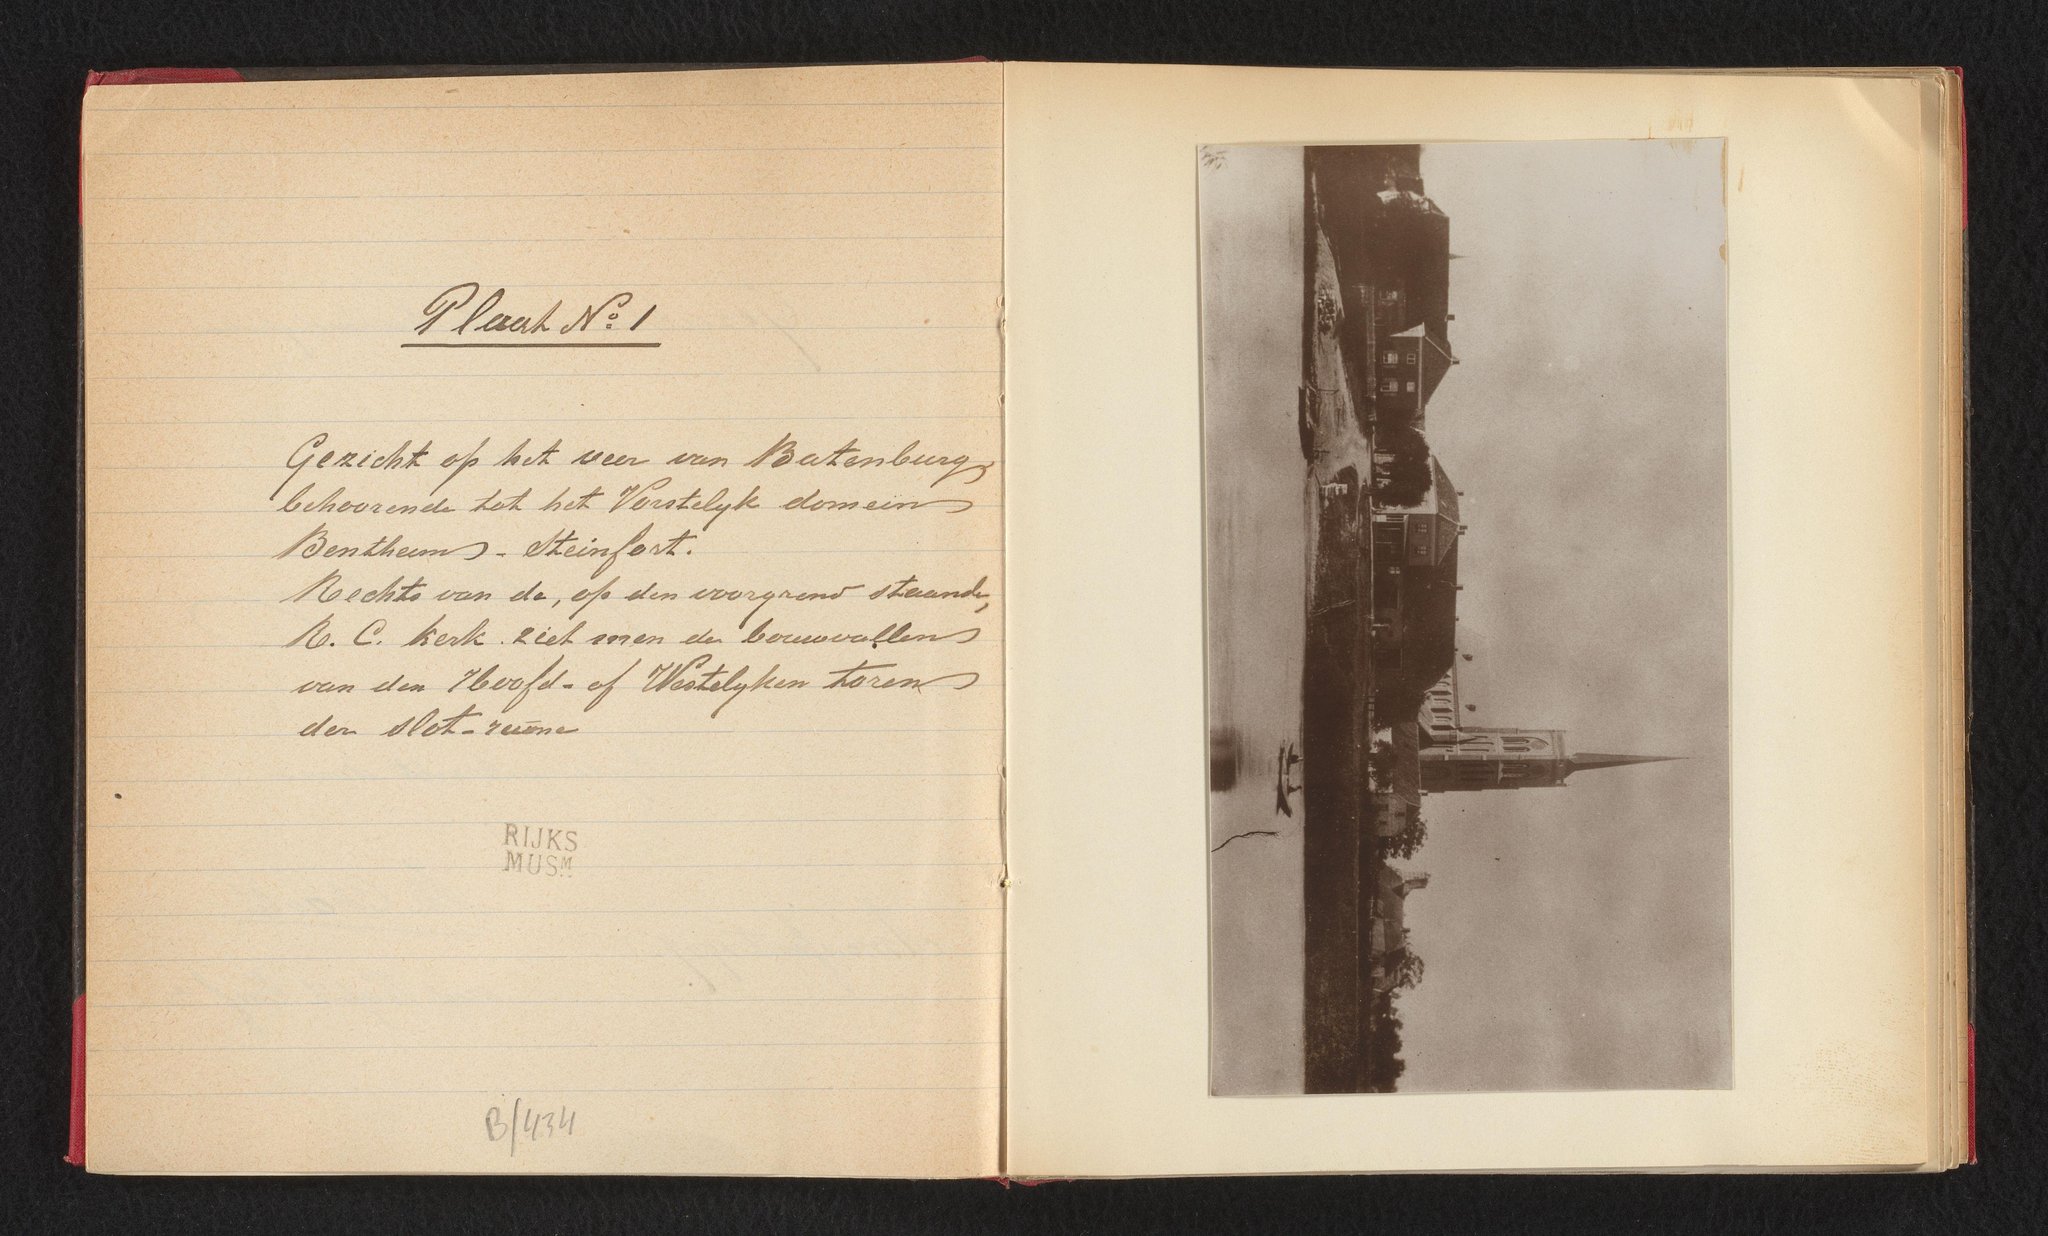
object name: photograph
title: Gezicht op Batenburg en de Sint-Victorkerk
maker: benjamin charlé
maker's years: 1845-1925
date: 1902-1907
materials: paper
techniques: collodion silver print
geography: batenburg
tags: church (exterior)